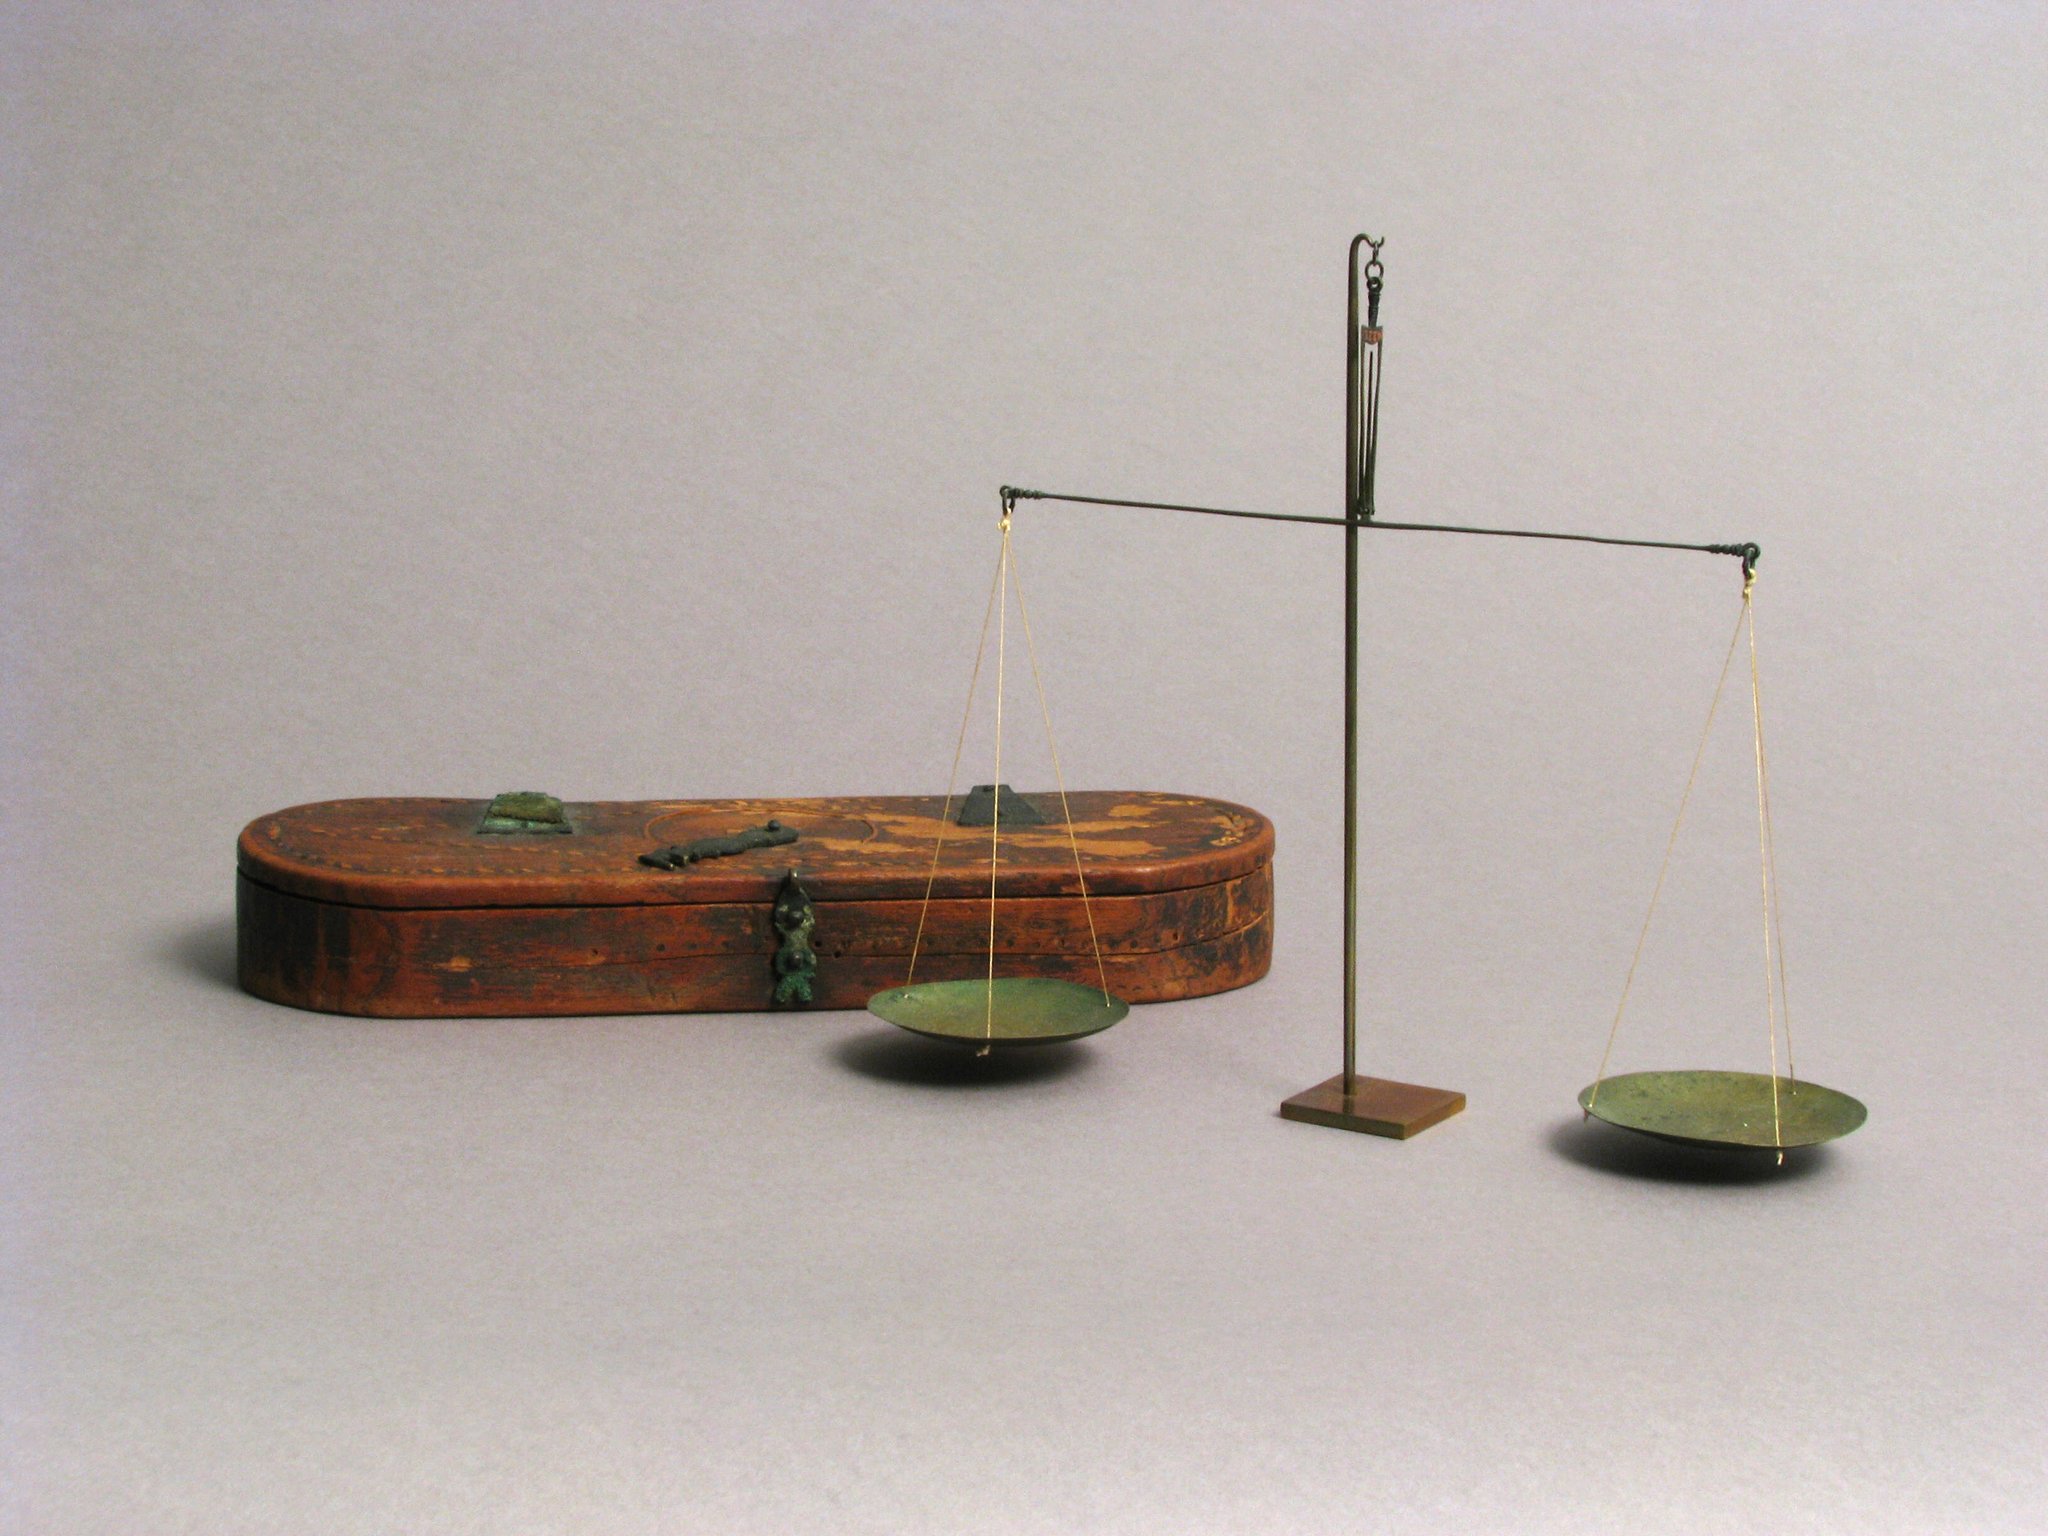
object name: box with balance scale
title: Wooden Box with Bronze Balance Scale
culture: coptic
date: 500-600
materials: copper alloy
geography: egypt